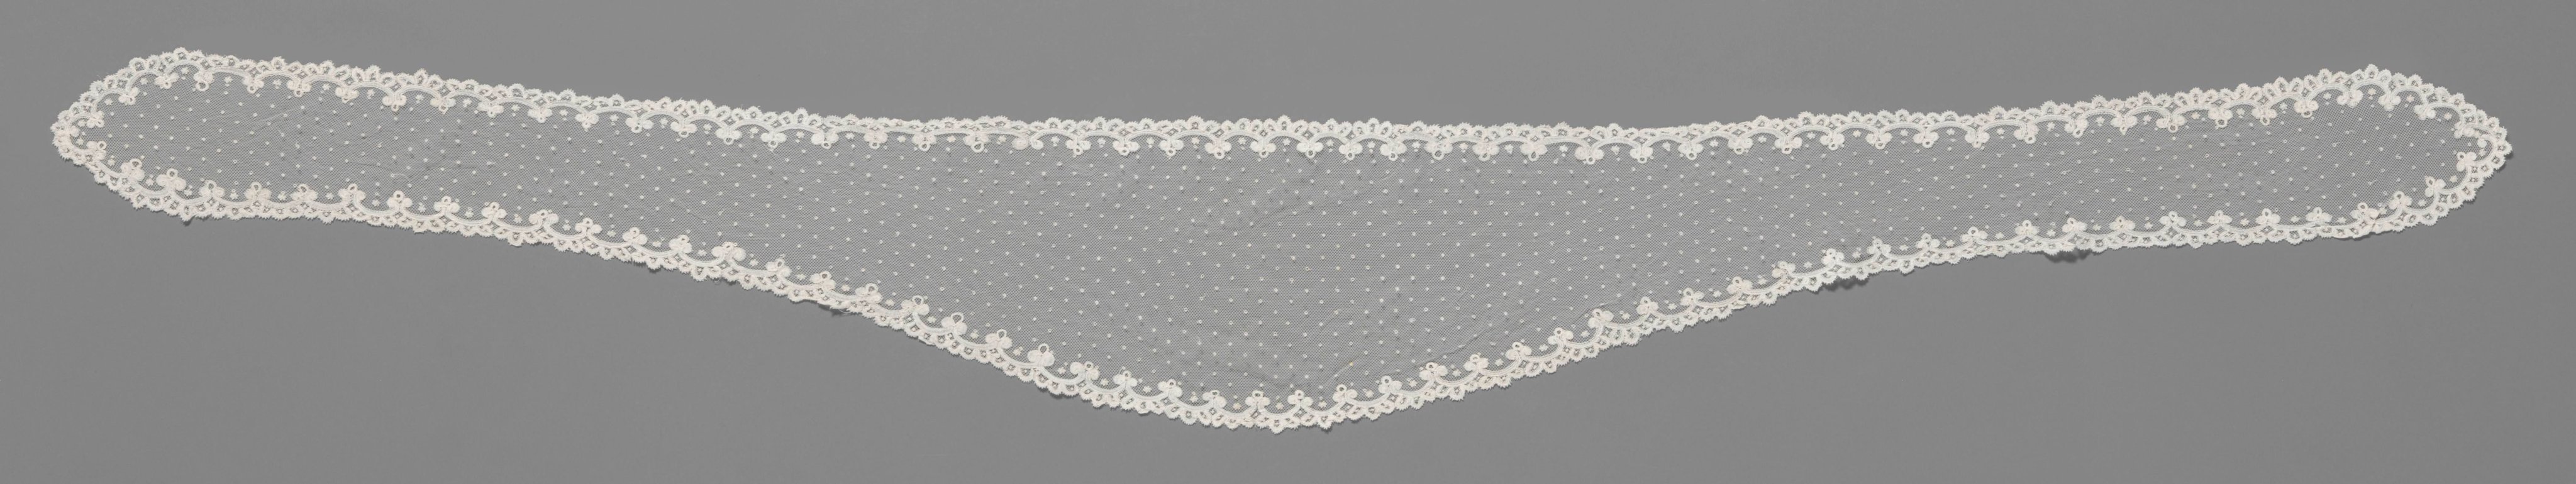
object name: fanchon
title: Fanchon van applicatiekant met moesjesfond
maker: Anonymous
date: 1870-1899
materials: linen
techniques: lace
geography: brussels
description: Fanchon van naturelkleurige applicatiekant, kloskant geappliceerd op machinale tule. Rond een met moesjes bezaaid mazenfond loopt een rand van boogjes van met een lusje verbonden liggende c-voluten, die langs de buitenkant versierd zijn met campanes.